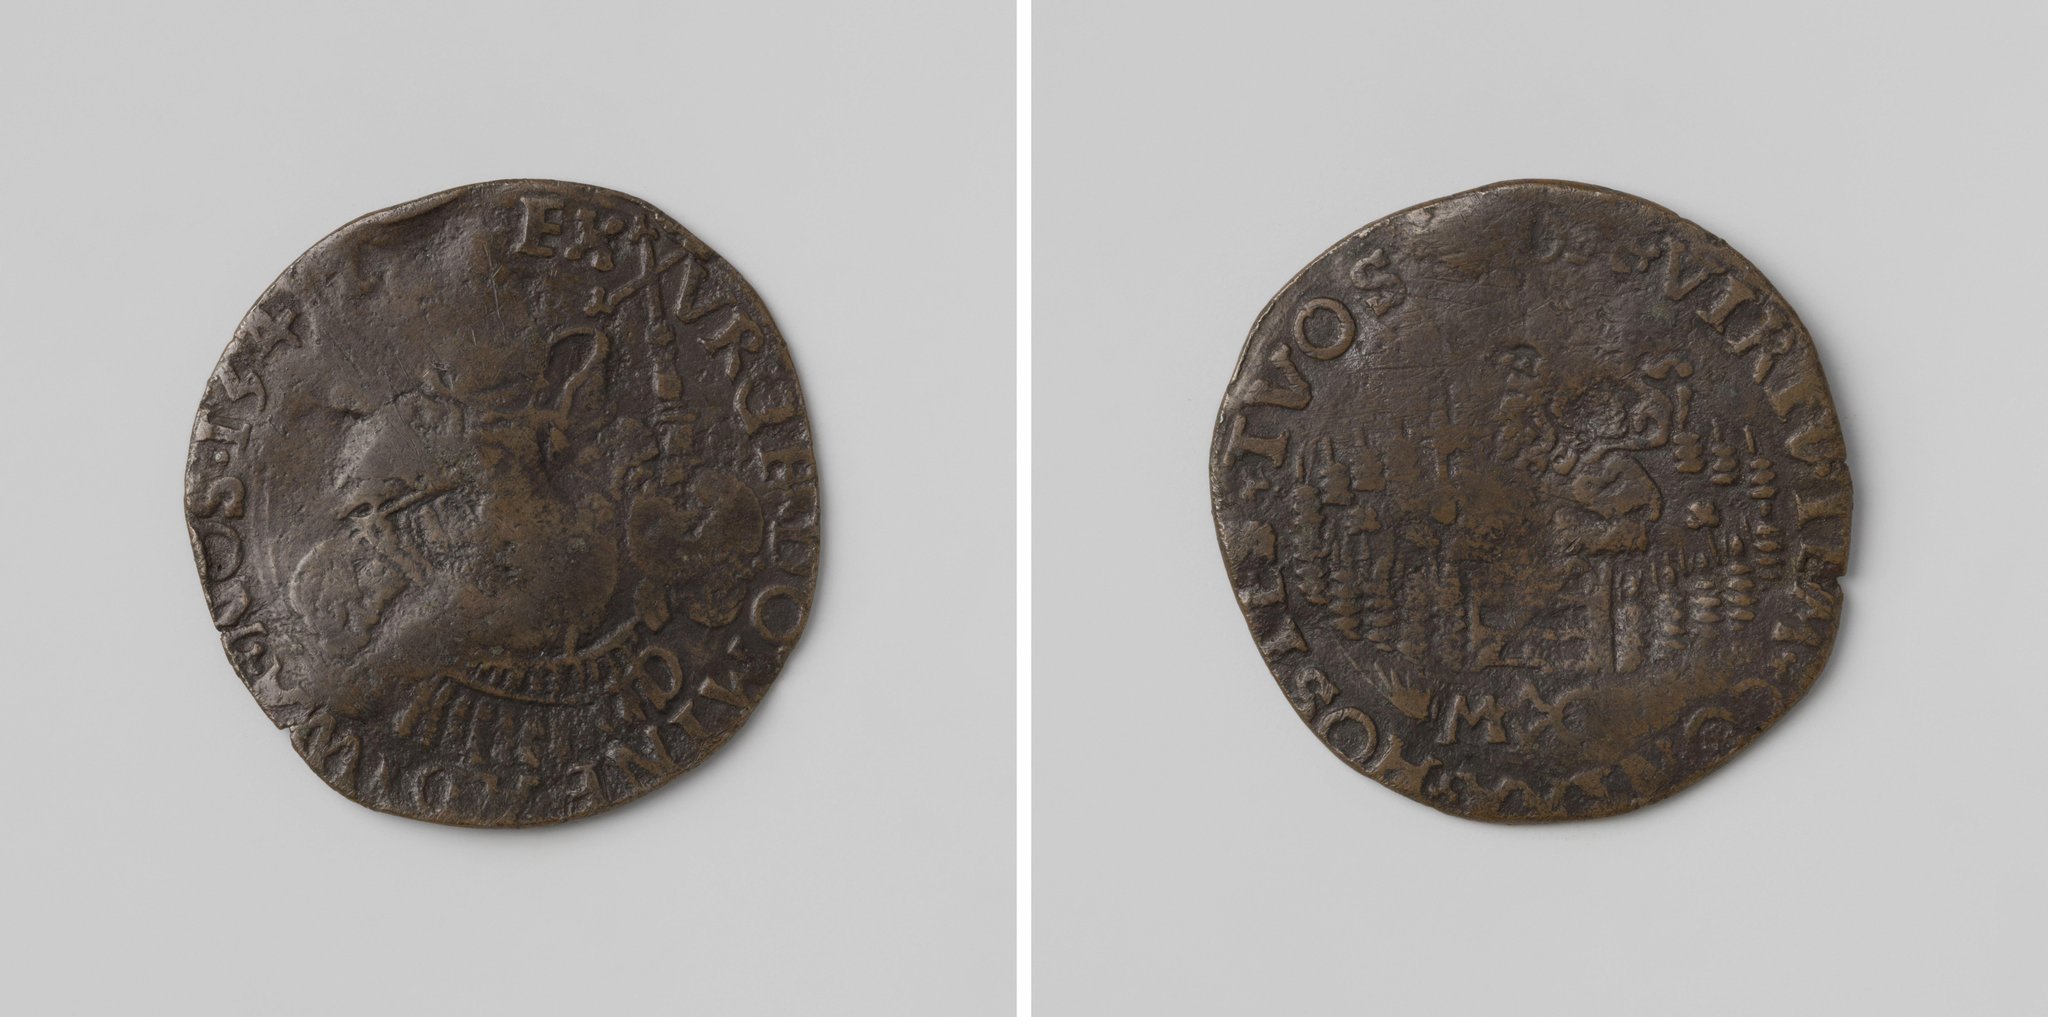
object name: jeton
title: Karel V, Duits keizer, bereidt zich voor op de oorlog tegen Maarten van Rossum, rekenpenning ten behoeve van Mr. Claes van Essche, lid van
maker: Anonymous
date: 1542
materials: copper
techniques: striking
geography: netherlands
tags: charles v (holy roman emperor and king of spain), holland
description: Koperen penning. Voorzijde: portret van Karel V met kroon, rijksappel in linkerhand en zwaard over rechterschouder binnen omschrift. Keerzijde: leeuw met vaandel in klauw, zittend in Hollandse tuin boven letters M en C, aan weerszijden van ruit binnen omschrift